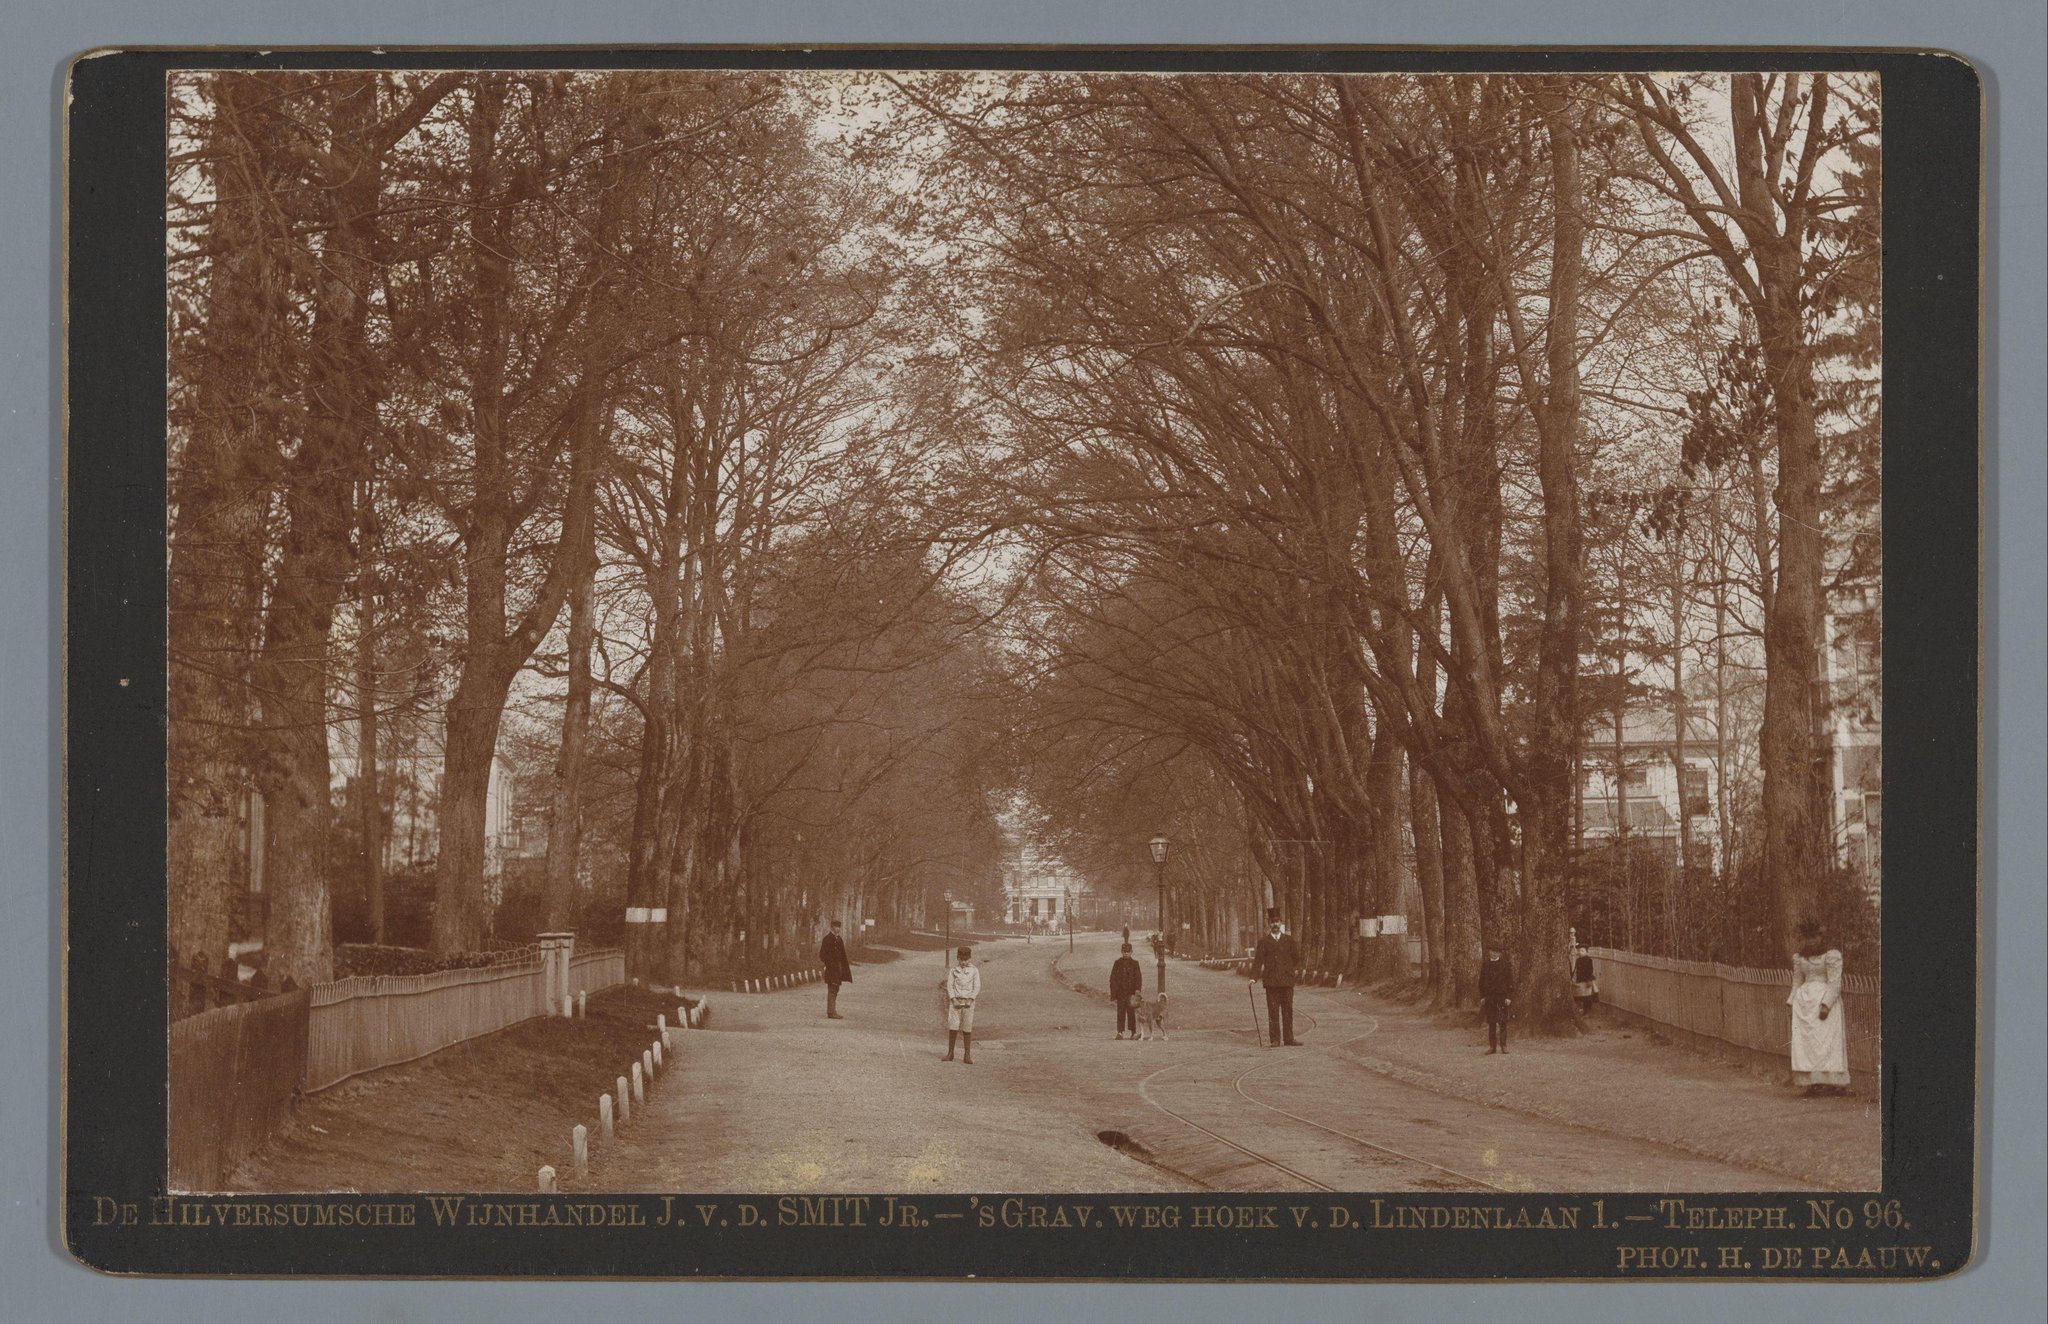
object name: cabinet photograph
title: De Hilversumsche Wijnhandel J.v.d. Smit Jr.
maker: henri de paauw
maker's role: fotograaf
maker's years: 1849-1922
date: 1896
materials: paper, cardboard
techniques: collodion silver print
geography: hilversum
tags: street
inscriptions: inscription: ‘-'s Grav.weg hoek v.d Lindenlaan 1.-Teleph.No 96/ Phot. H. de Paauw’, inscription: ‘1896’